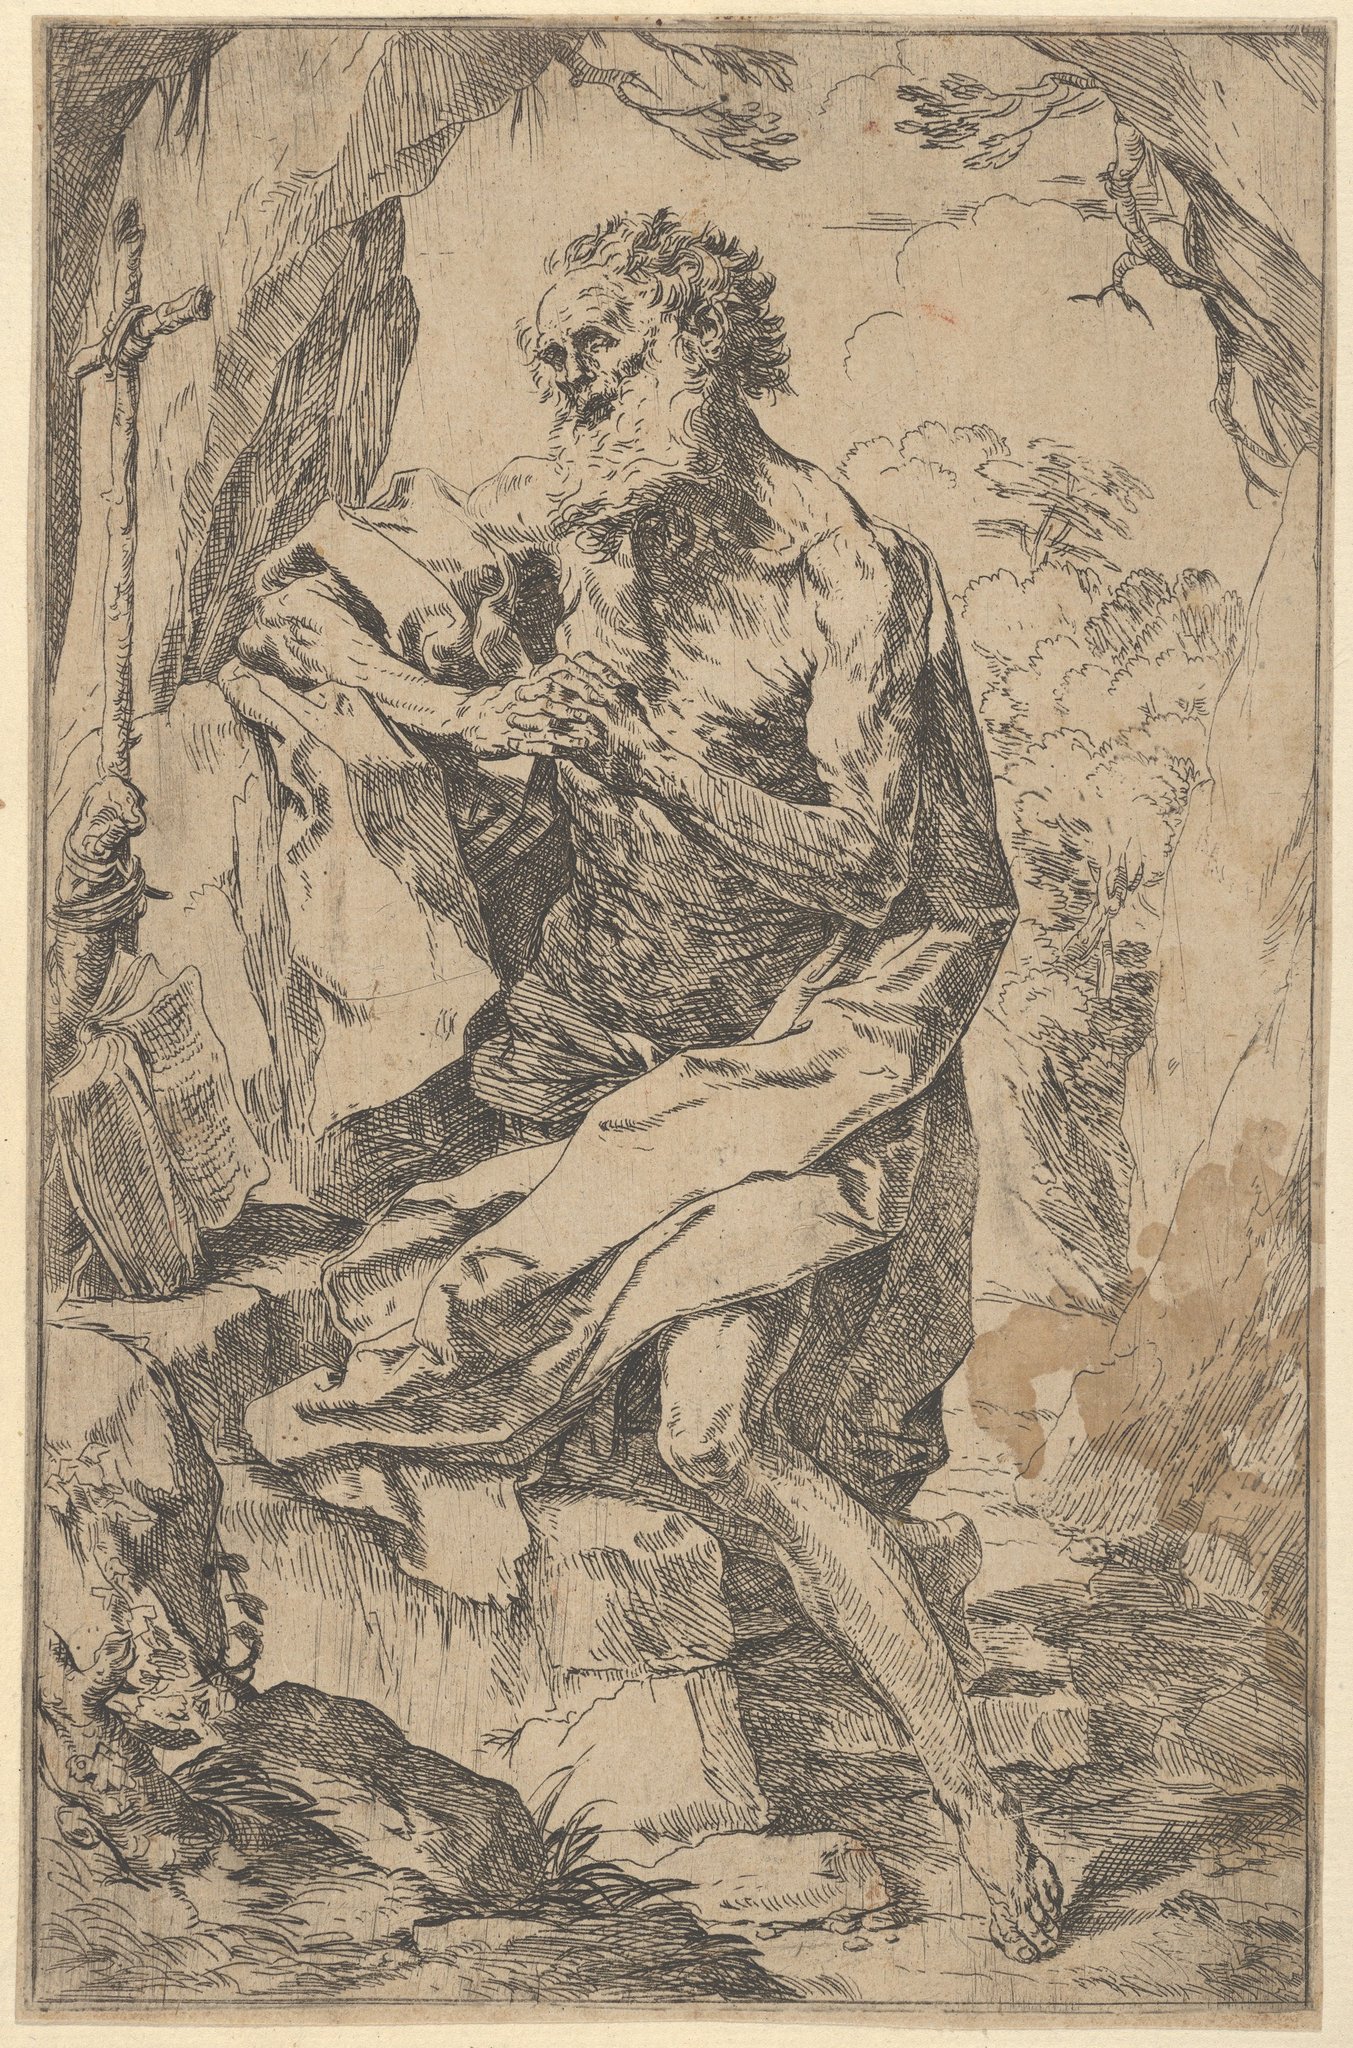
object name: print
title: Saint Jerome kneeling on a rock in front of a cross and an open book facing left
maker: guido reni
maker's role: artist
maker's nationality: italian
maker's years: 1575-1642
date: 1600-1640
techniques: etching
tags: books,saint jerome,cross